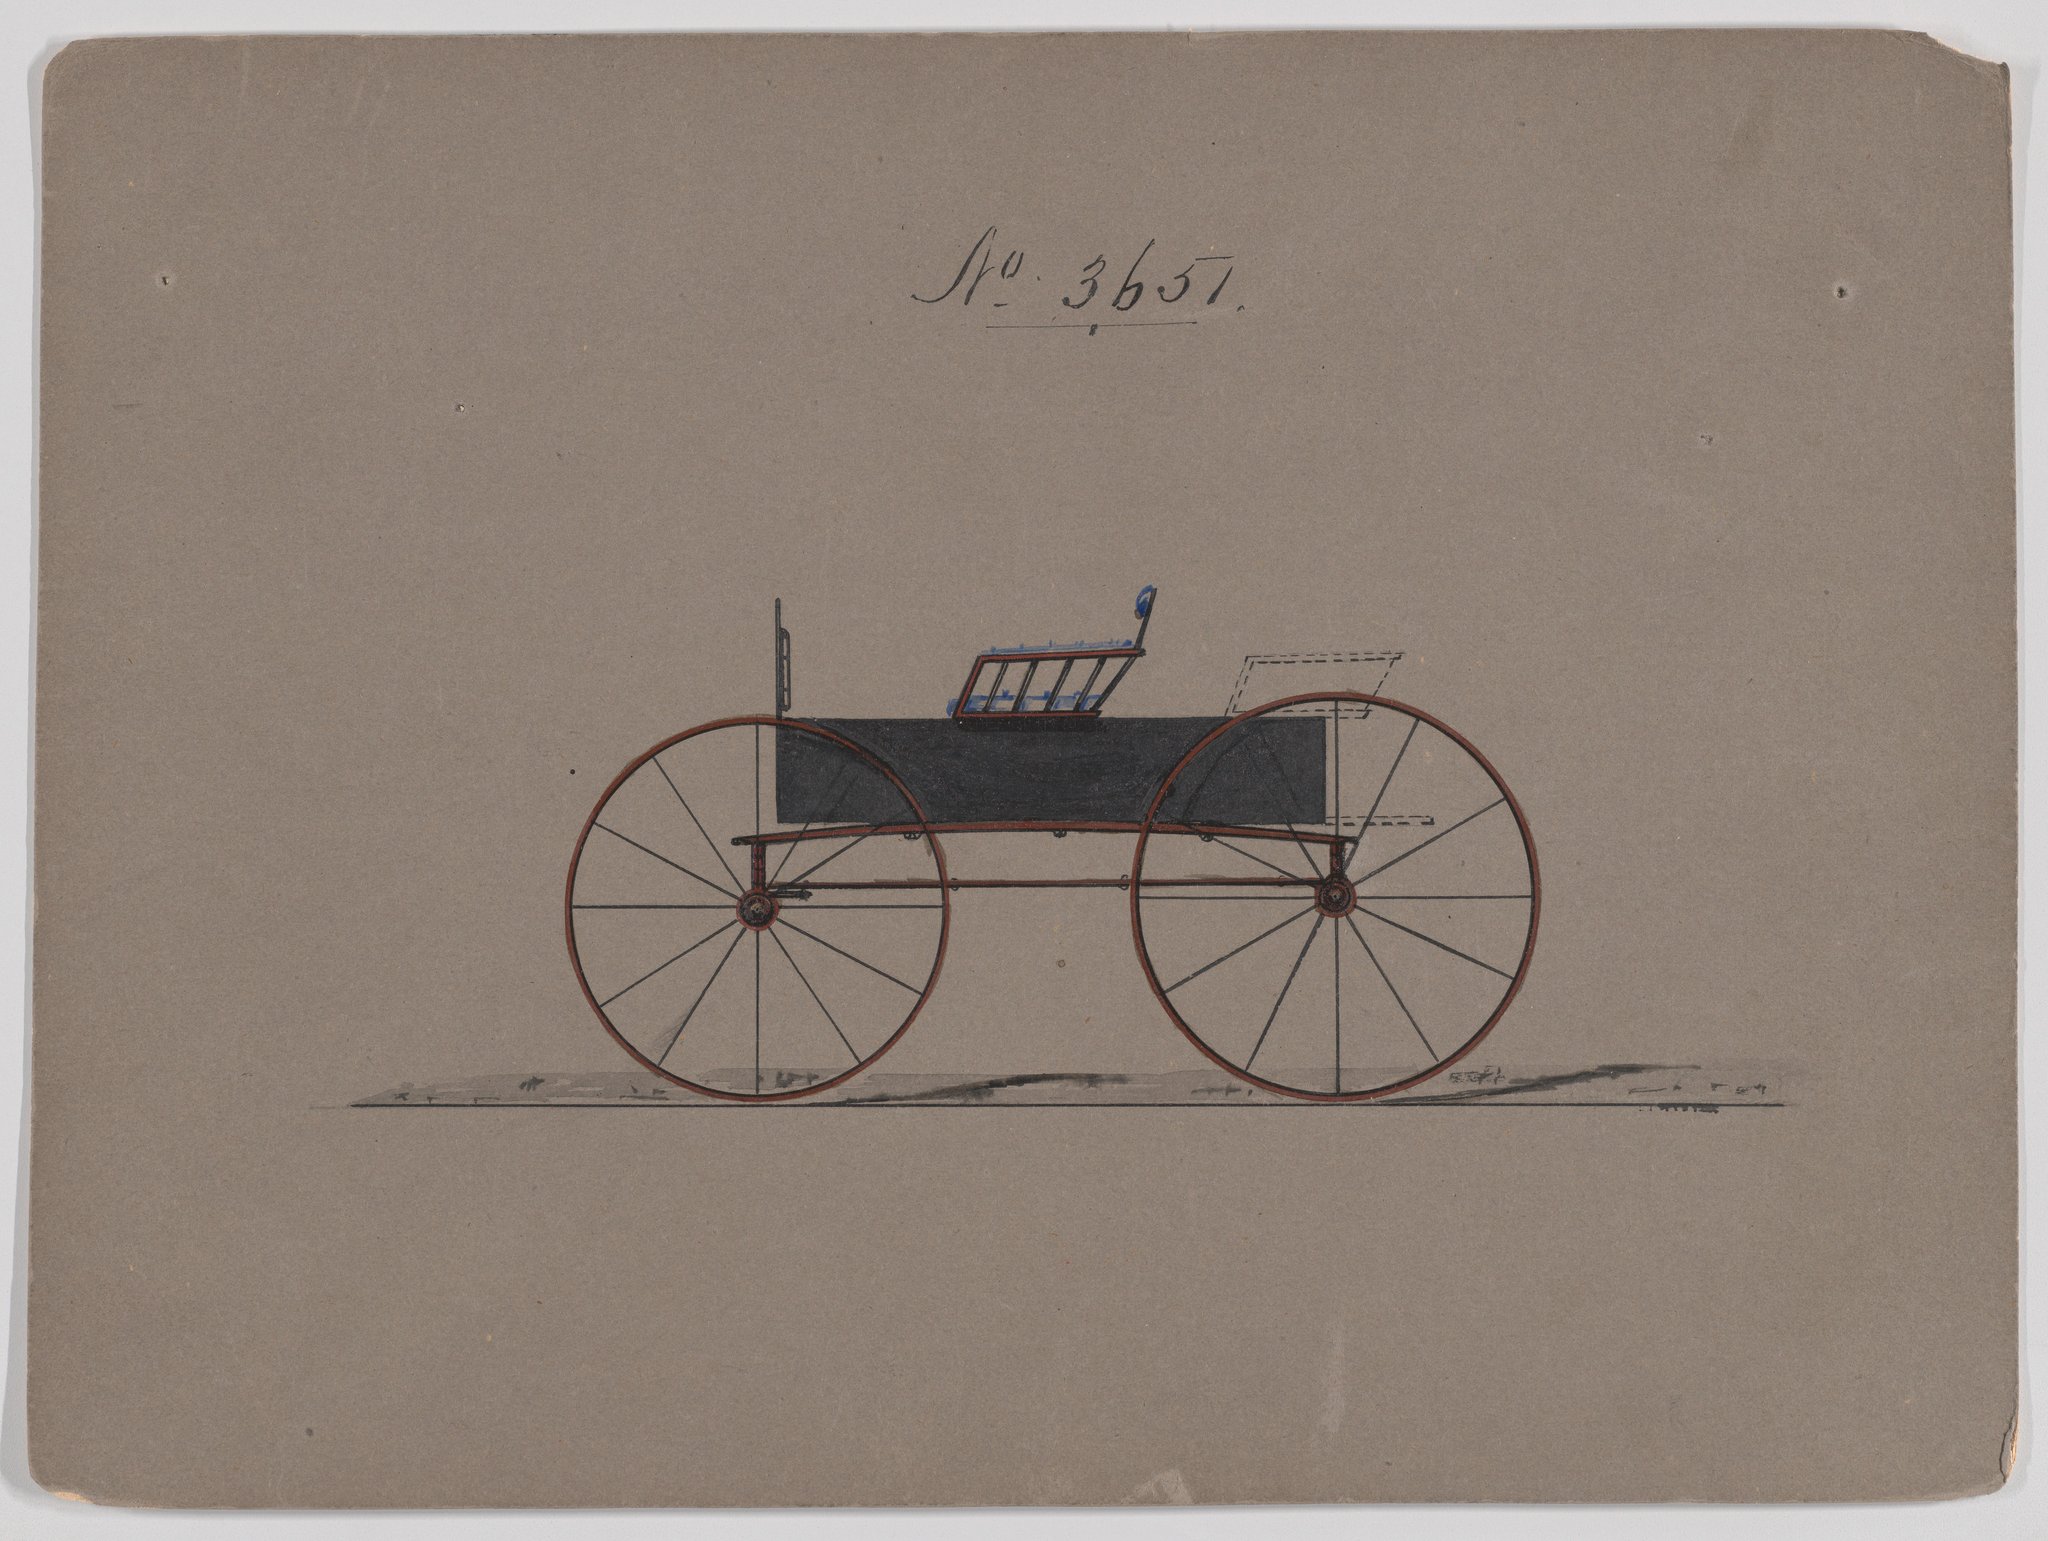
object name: drawing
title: Design for T-Cart, no. 3651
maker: brewster & co.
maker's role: manufacturer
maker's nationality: american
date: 1881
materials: gouache, gum arabic, ink, watercolor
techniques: pen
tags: carriages